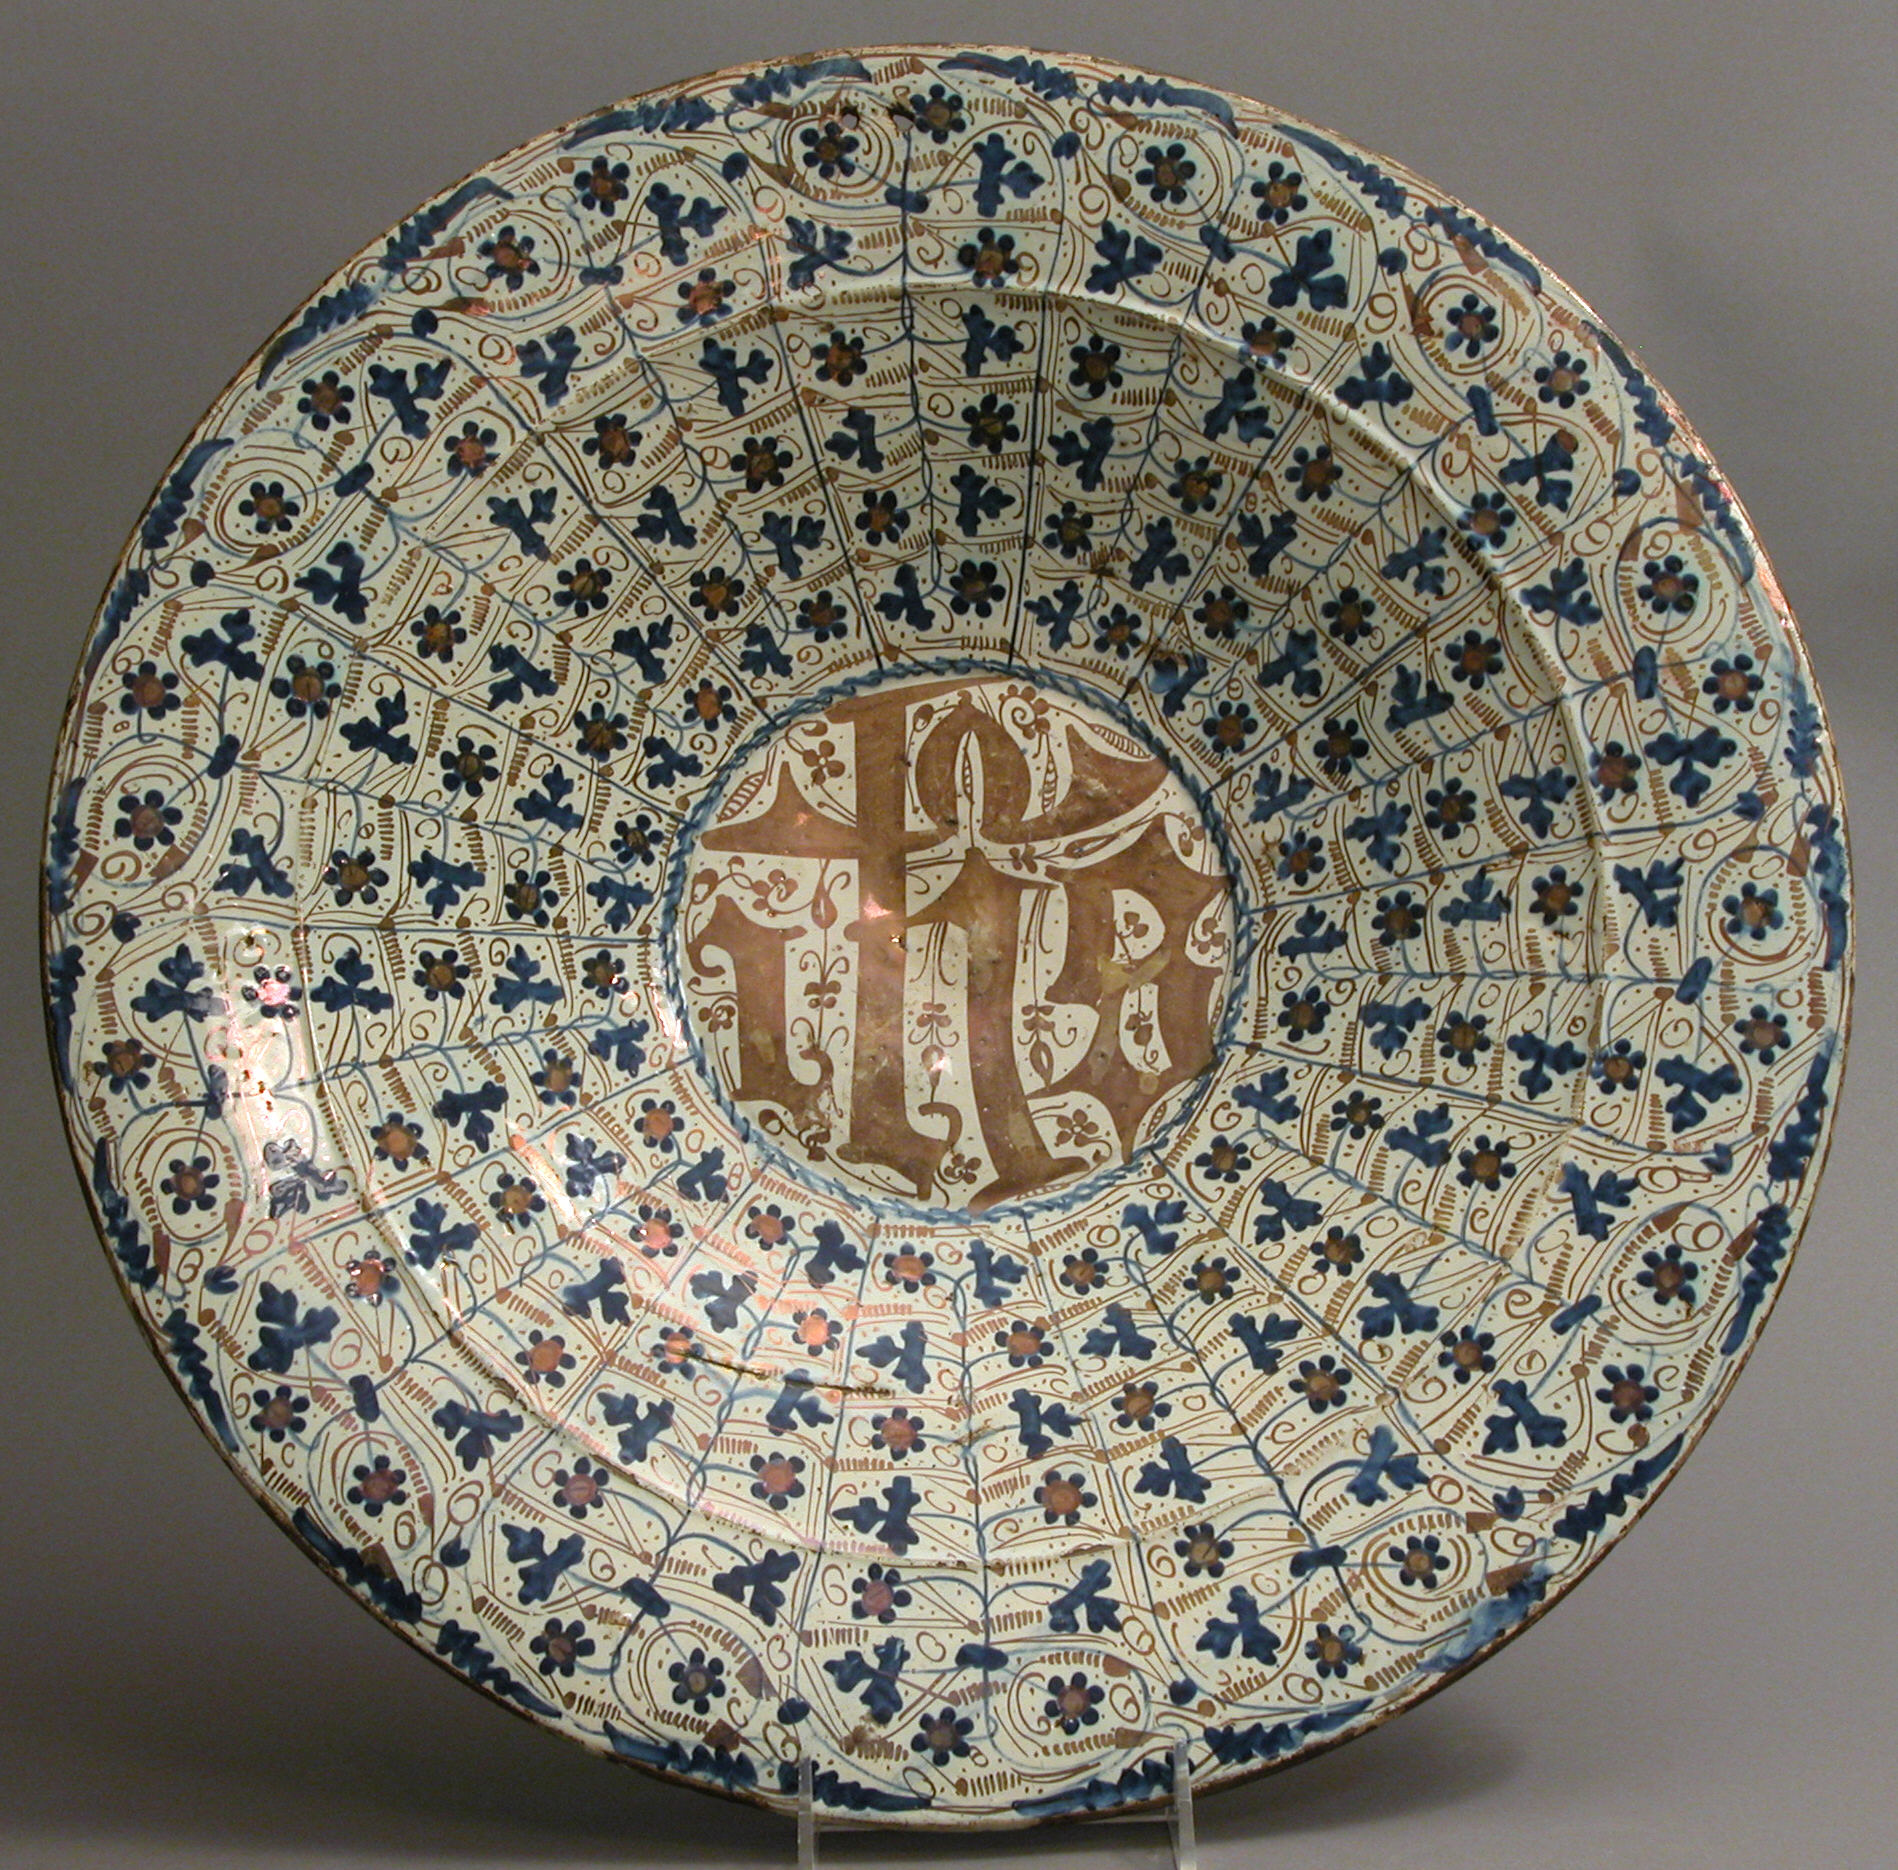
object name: dish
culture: spanish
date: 1430-1460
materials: earthenware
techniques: glazing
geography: spain